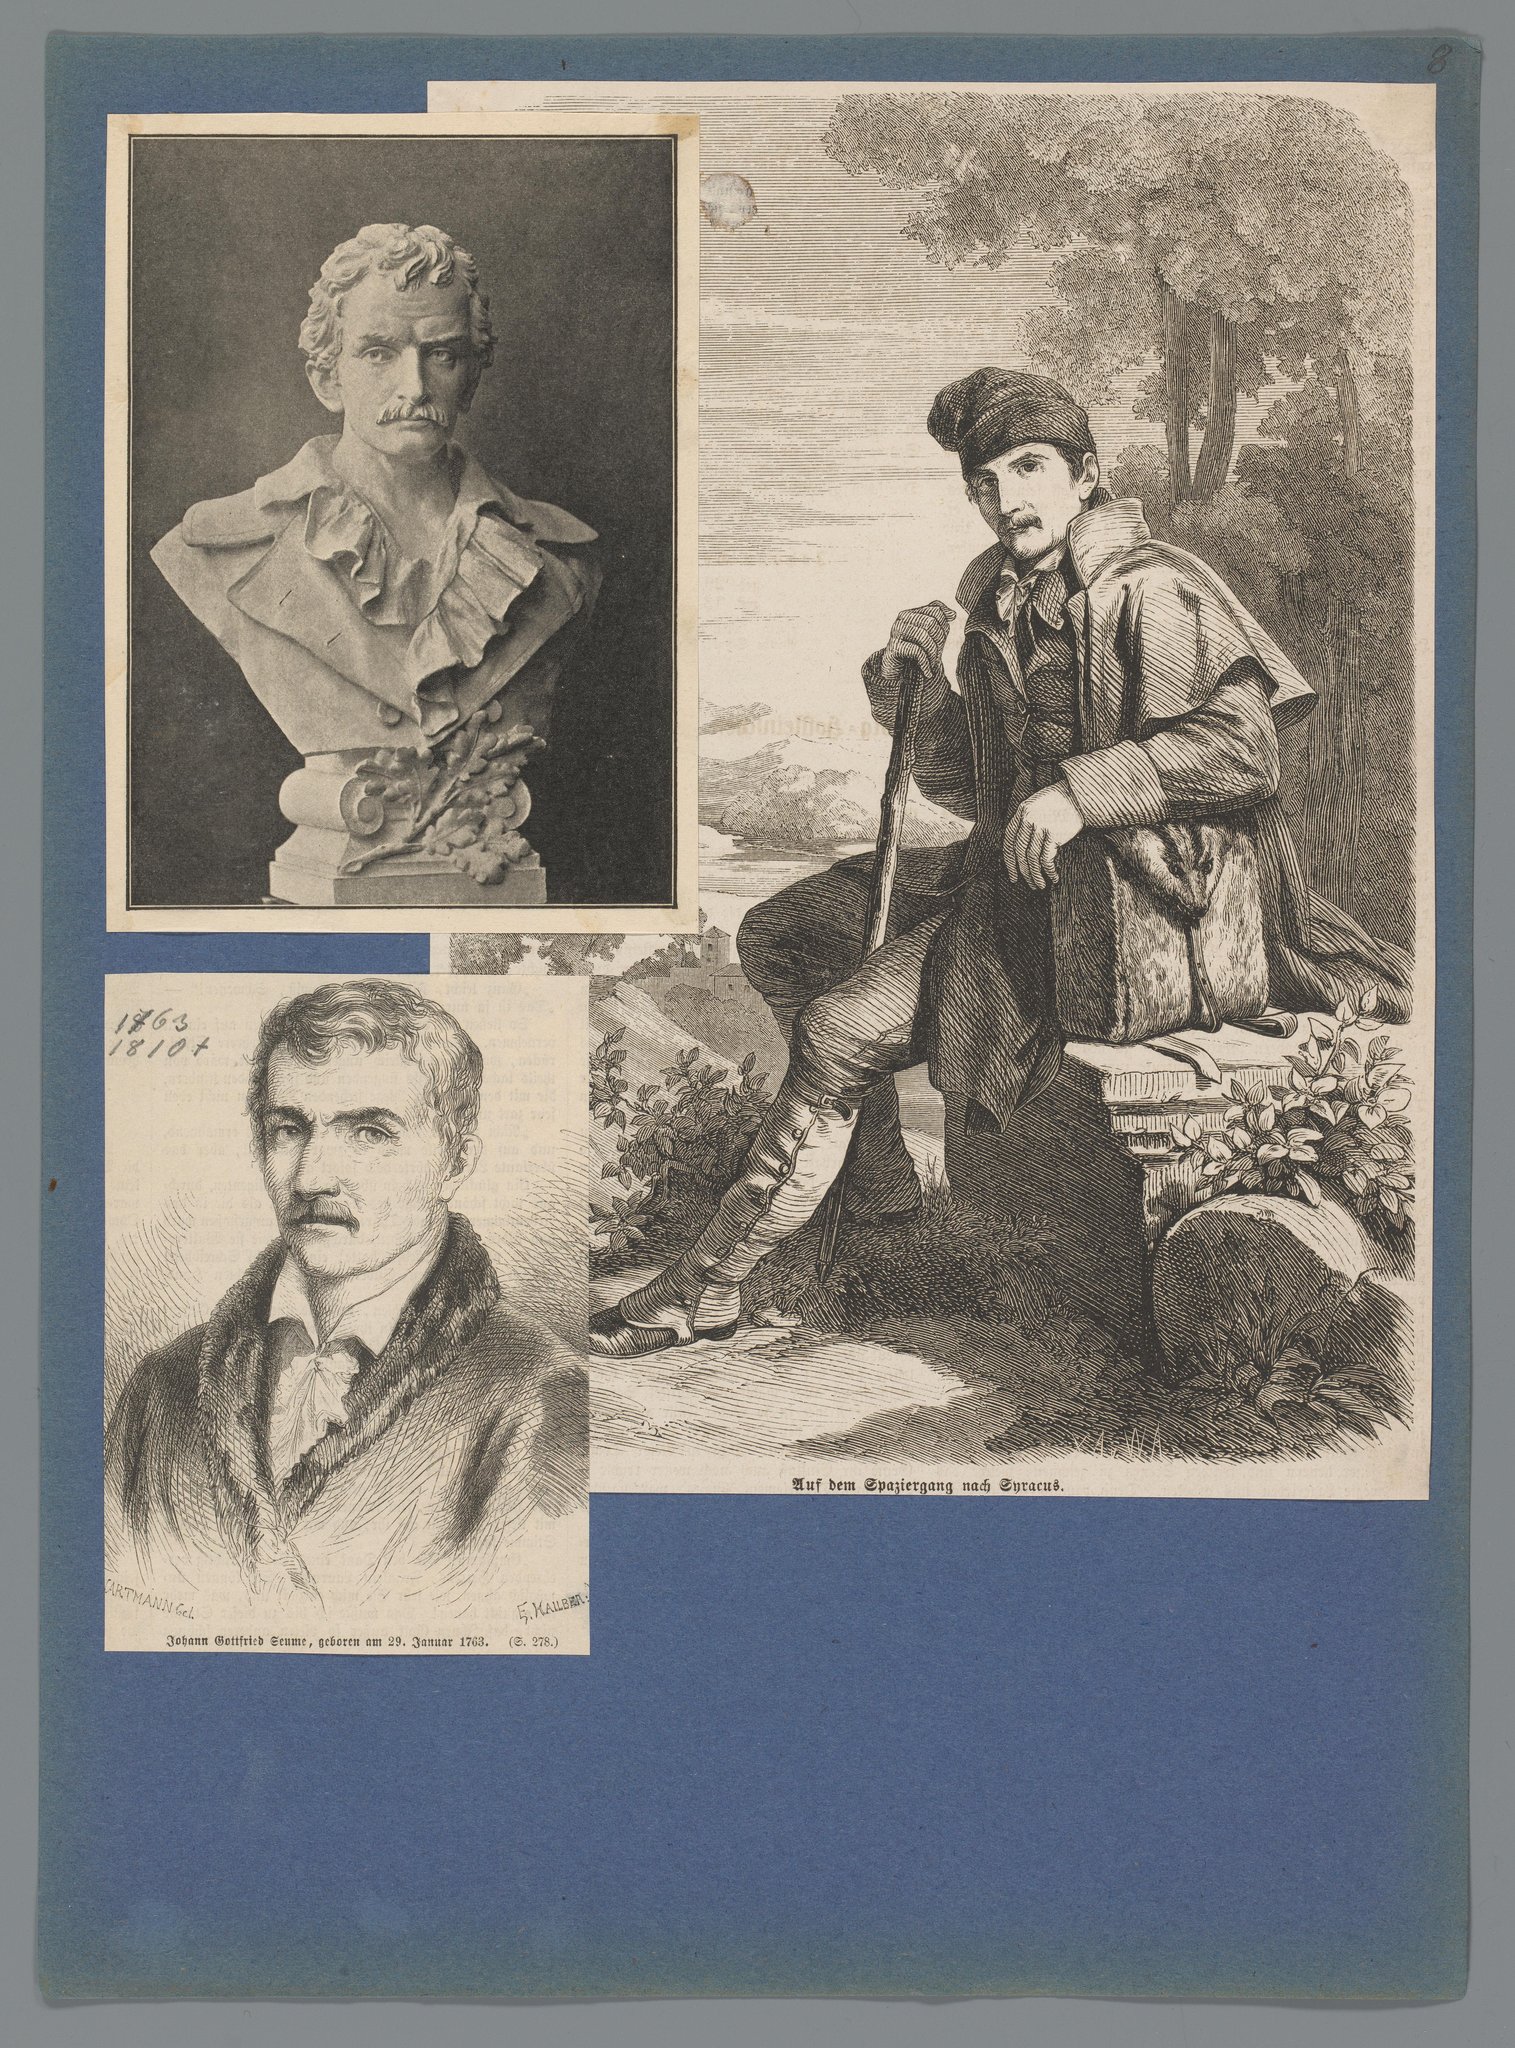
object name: sheet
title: Blad met twee portretten van Johann Gottfried Seume en een afbeelding van zijn borstbeeld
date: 1850-1900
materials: paper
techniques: letterpress printing, snipping, engraving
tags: historical persons, portrait of a writer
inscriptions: number: ‘8’, signature: ‘Hartmann. Gel.’